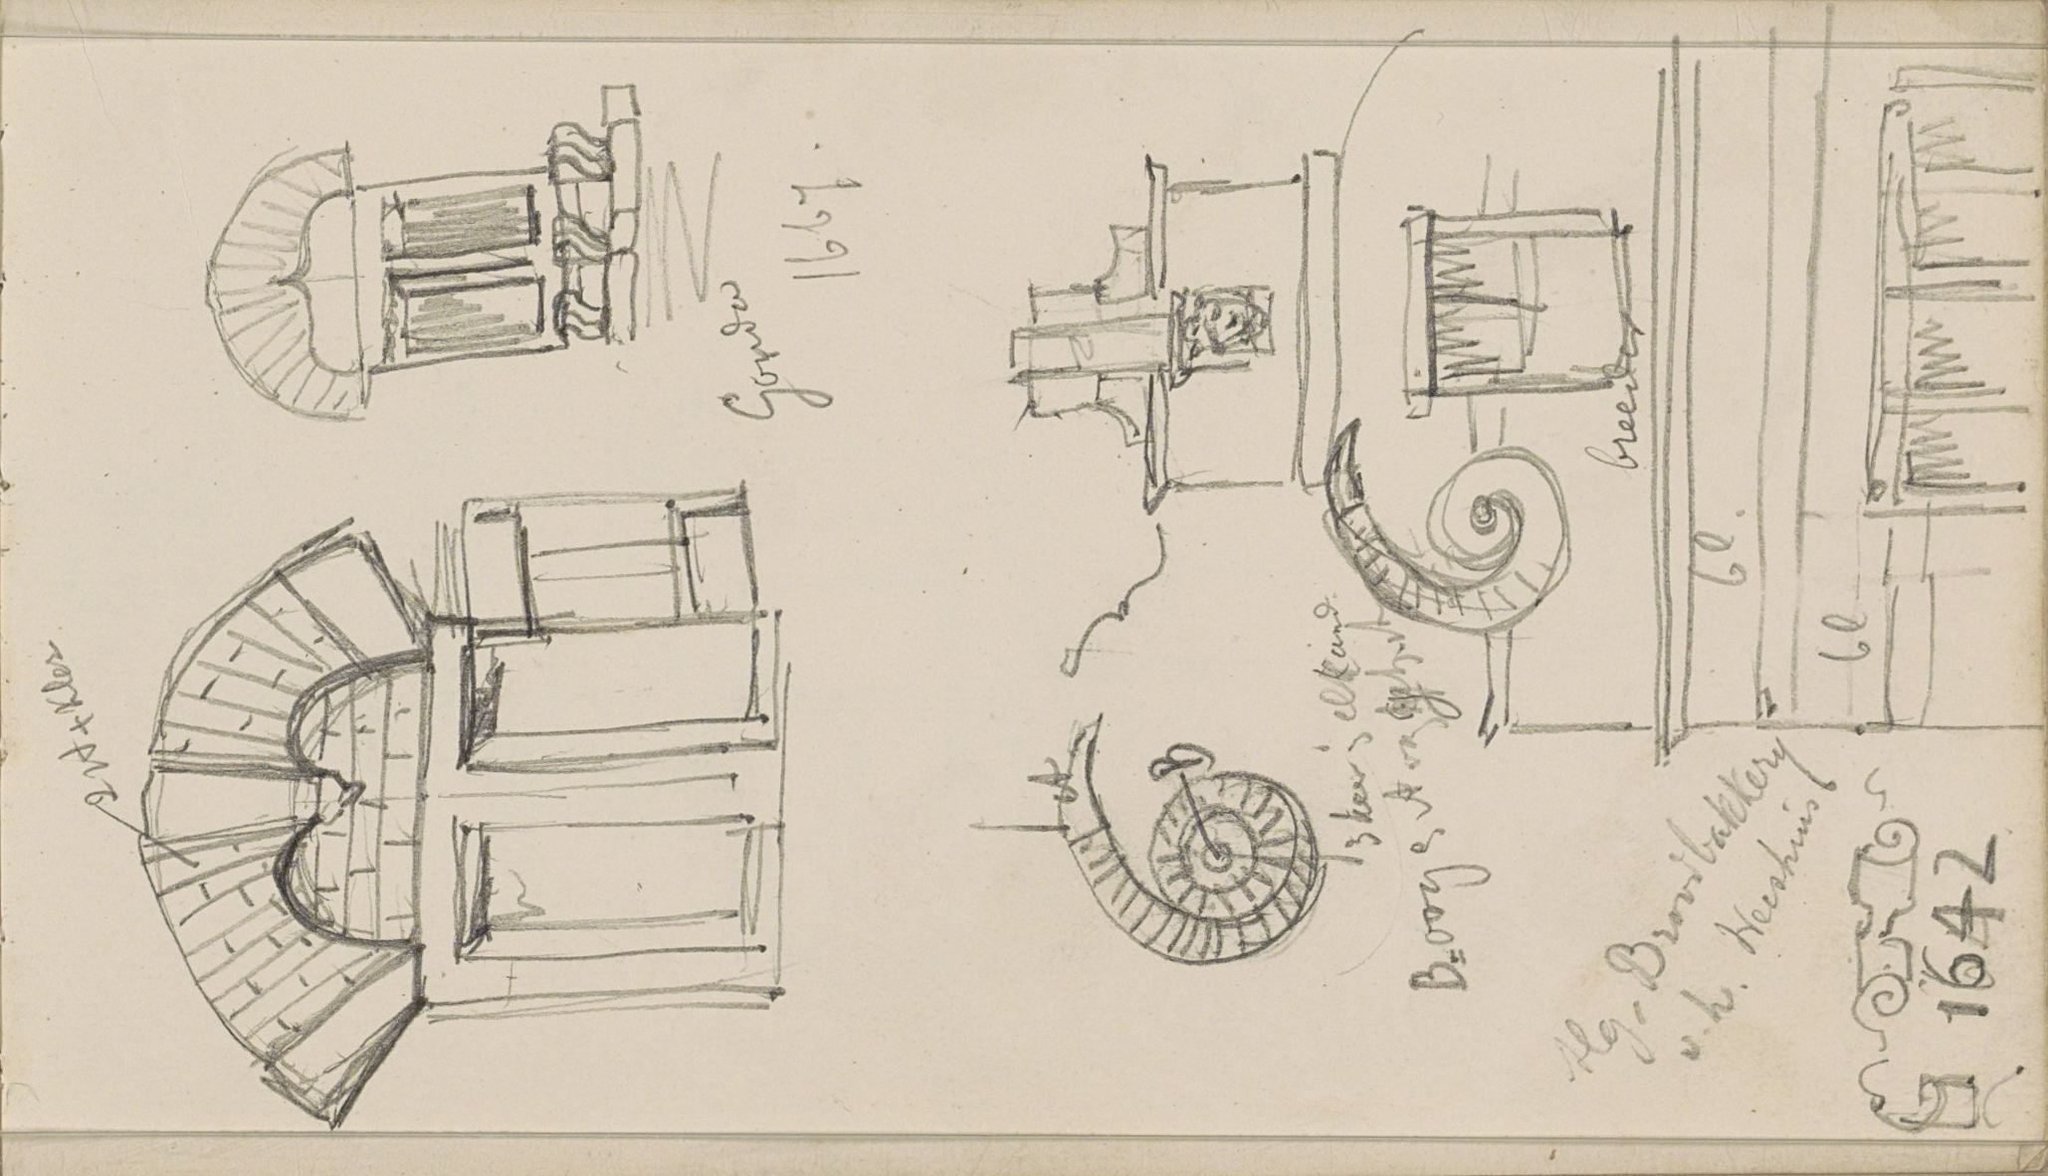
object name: sketchbook leaf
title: Gevel van het Weeshuis te Gouda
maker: isaac gosschalk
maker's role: draughtsman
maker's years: 1838-1907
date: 1866-1868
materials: paper, pencil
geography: gouda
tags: window, architectural detail, gouda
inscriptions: annotation: ‘2 st +kle[...]/ Gouda/ 1667/ [...]/ Boog [...]/ Hg. Broodbakkerij/ v.h. Weeshuis/ breeder/ 1642’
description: Tevens studies van details van gevels in Gouda. Blad 41 recto uit een schetsboek met 67 bladen.